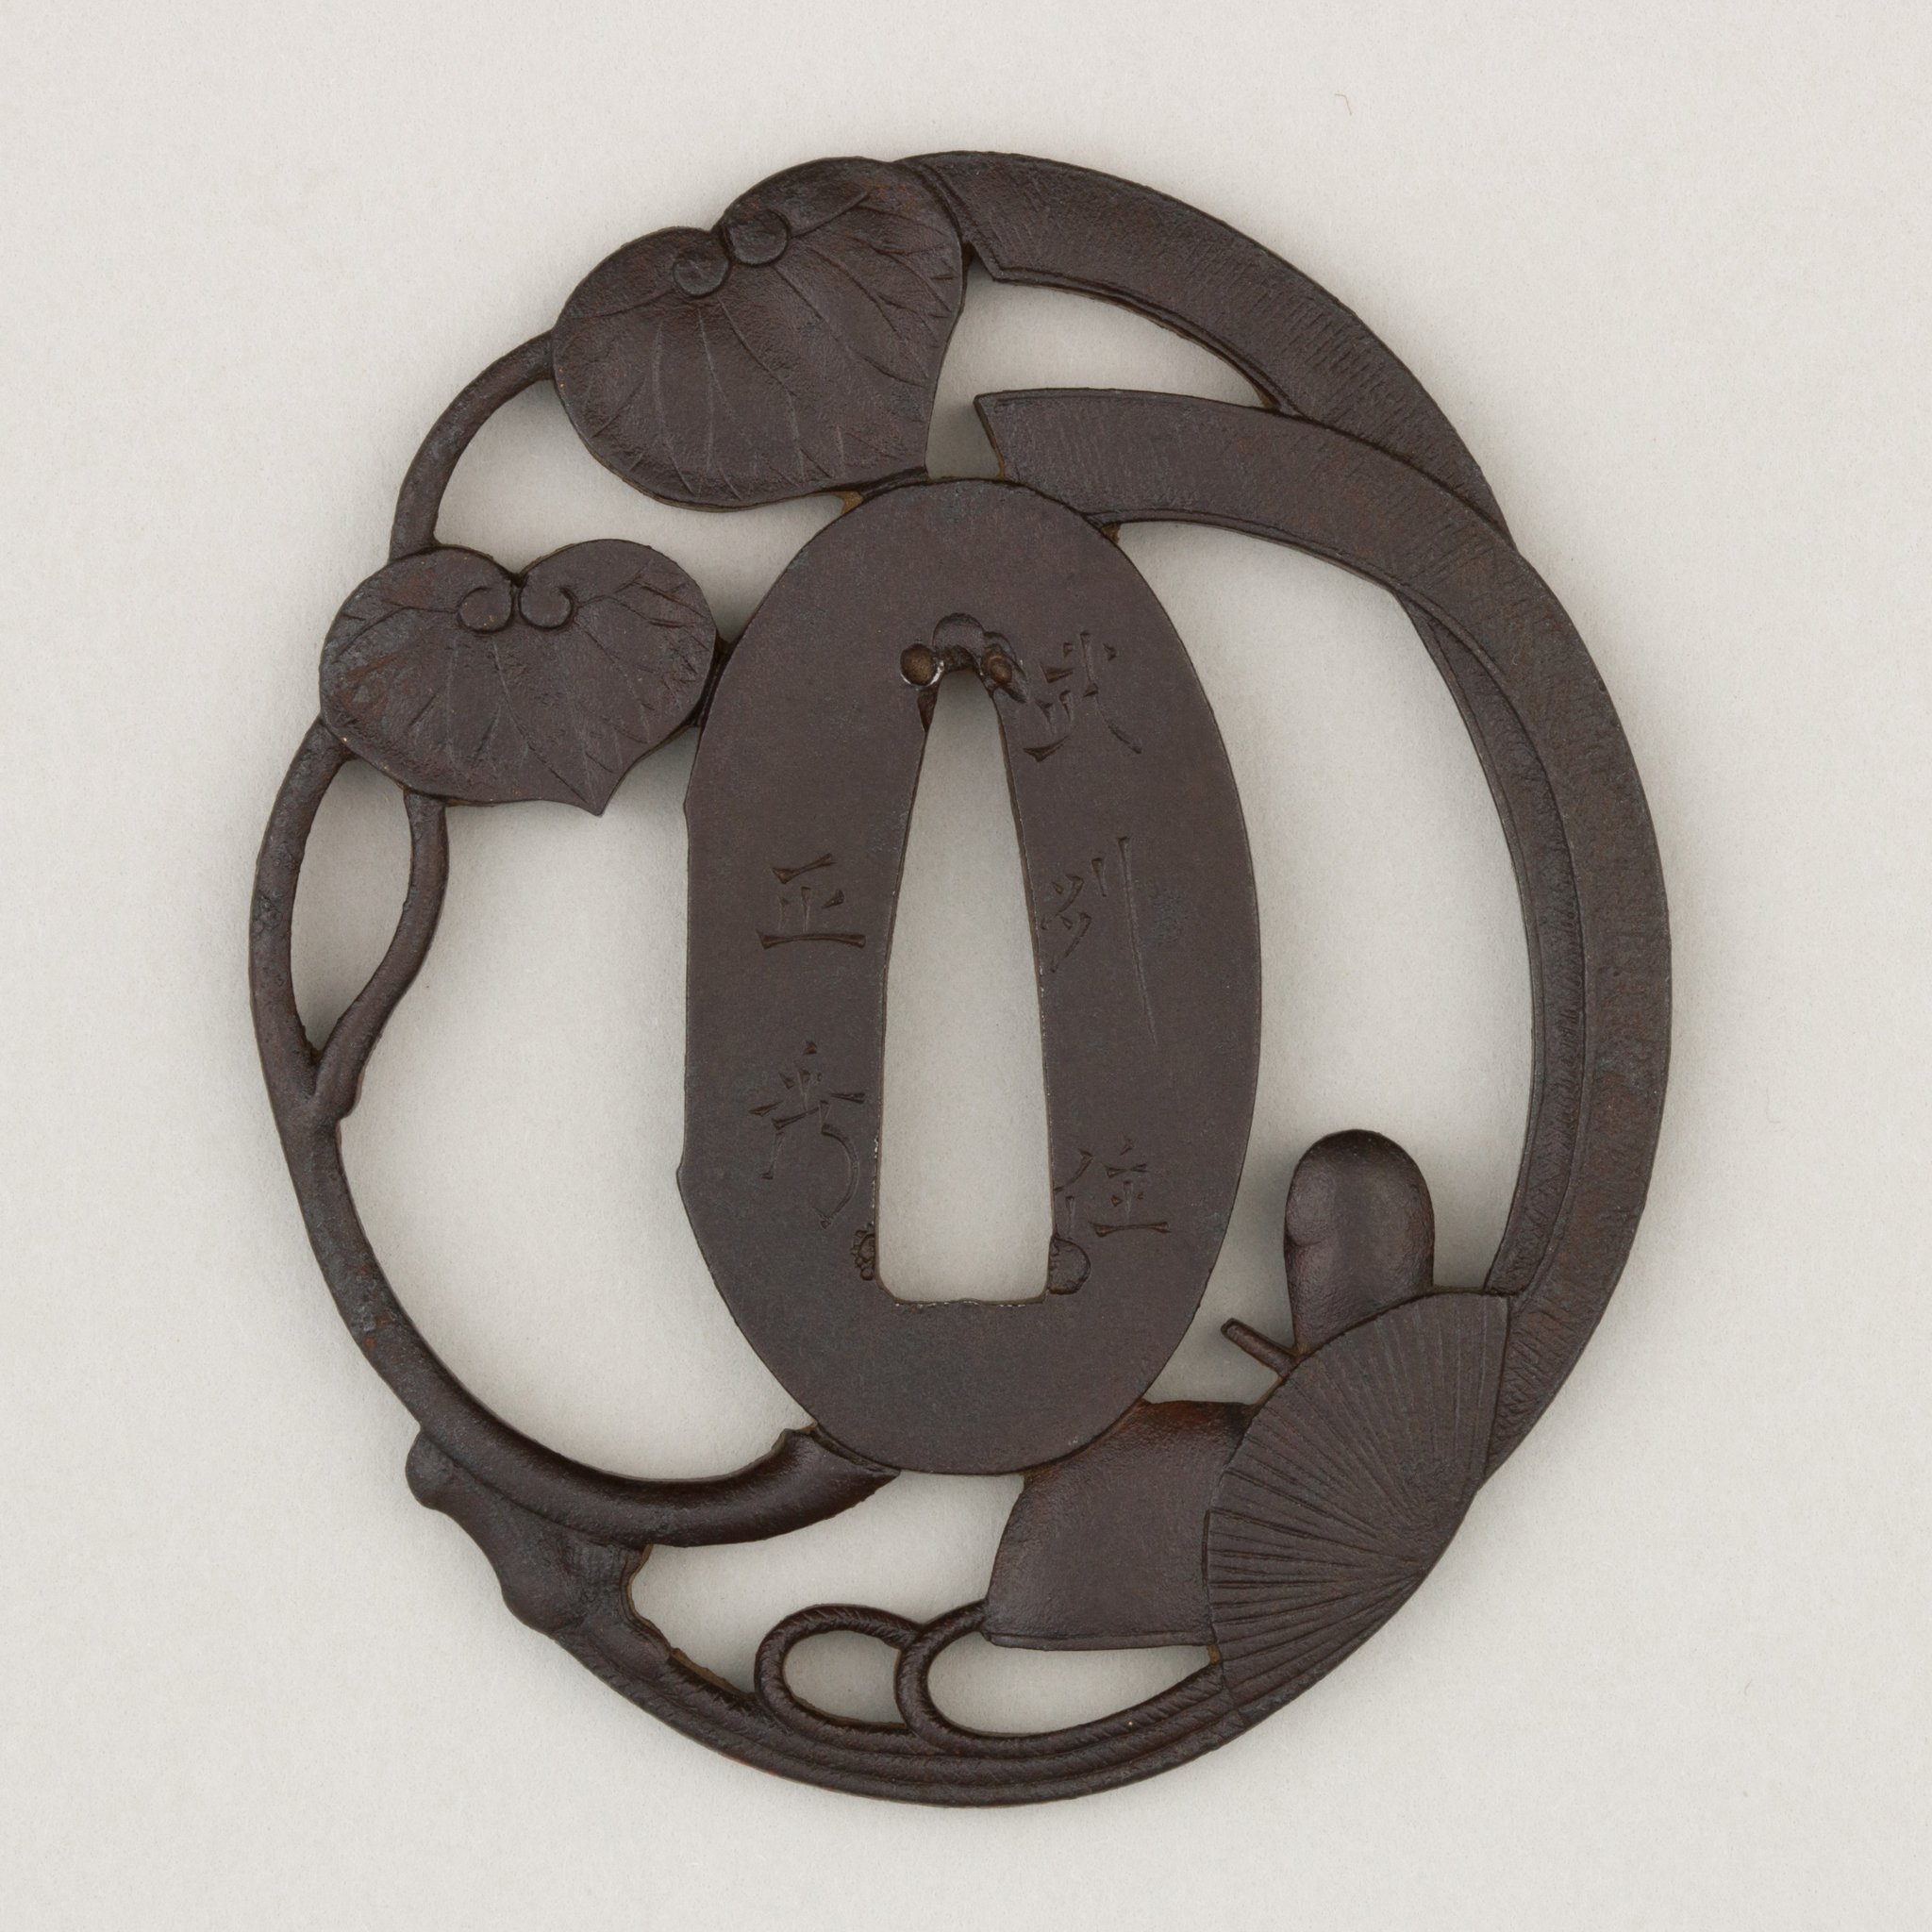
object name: sword guard tsuba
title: Sword Guard (Tsuba)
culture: japanese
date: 1701-1800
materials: copper, iron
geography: japan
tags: leaves